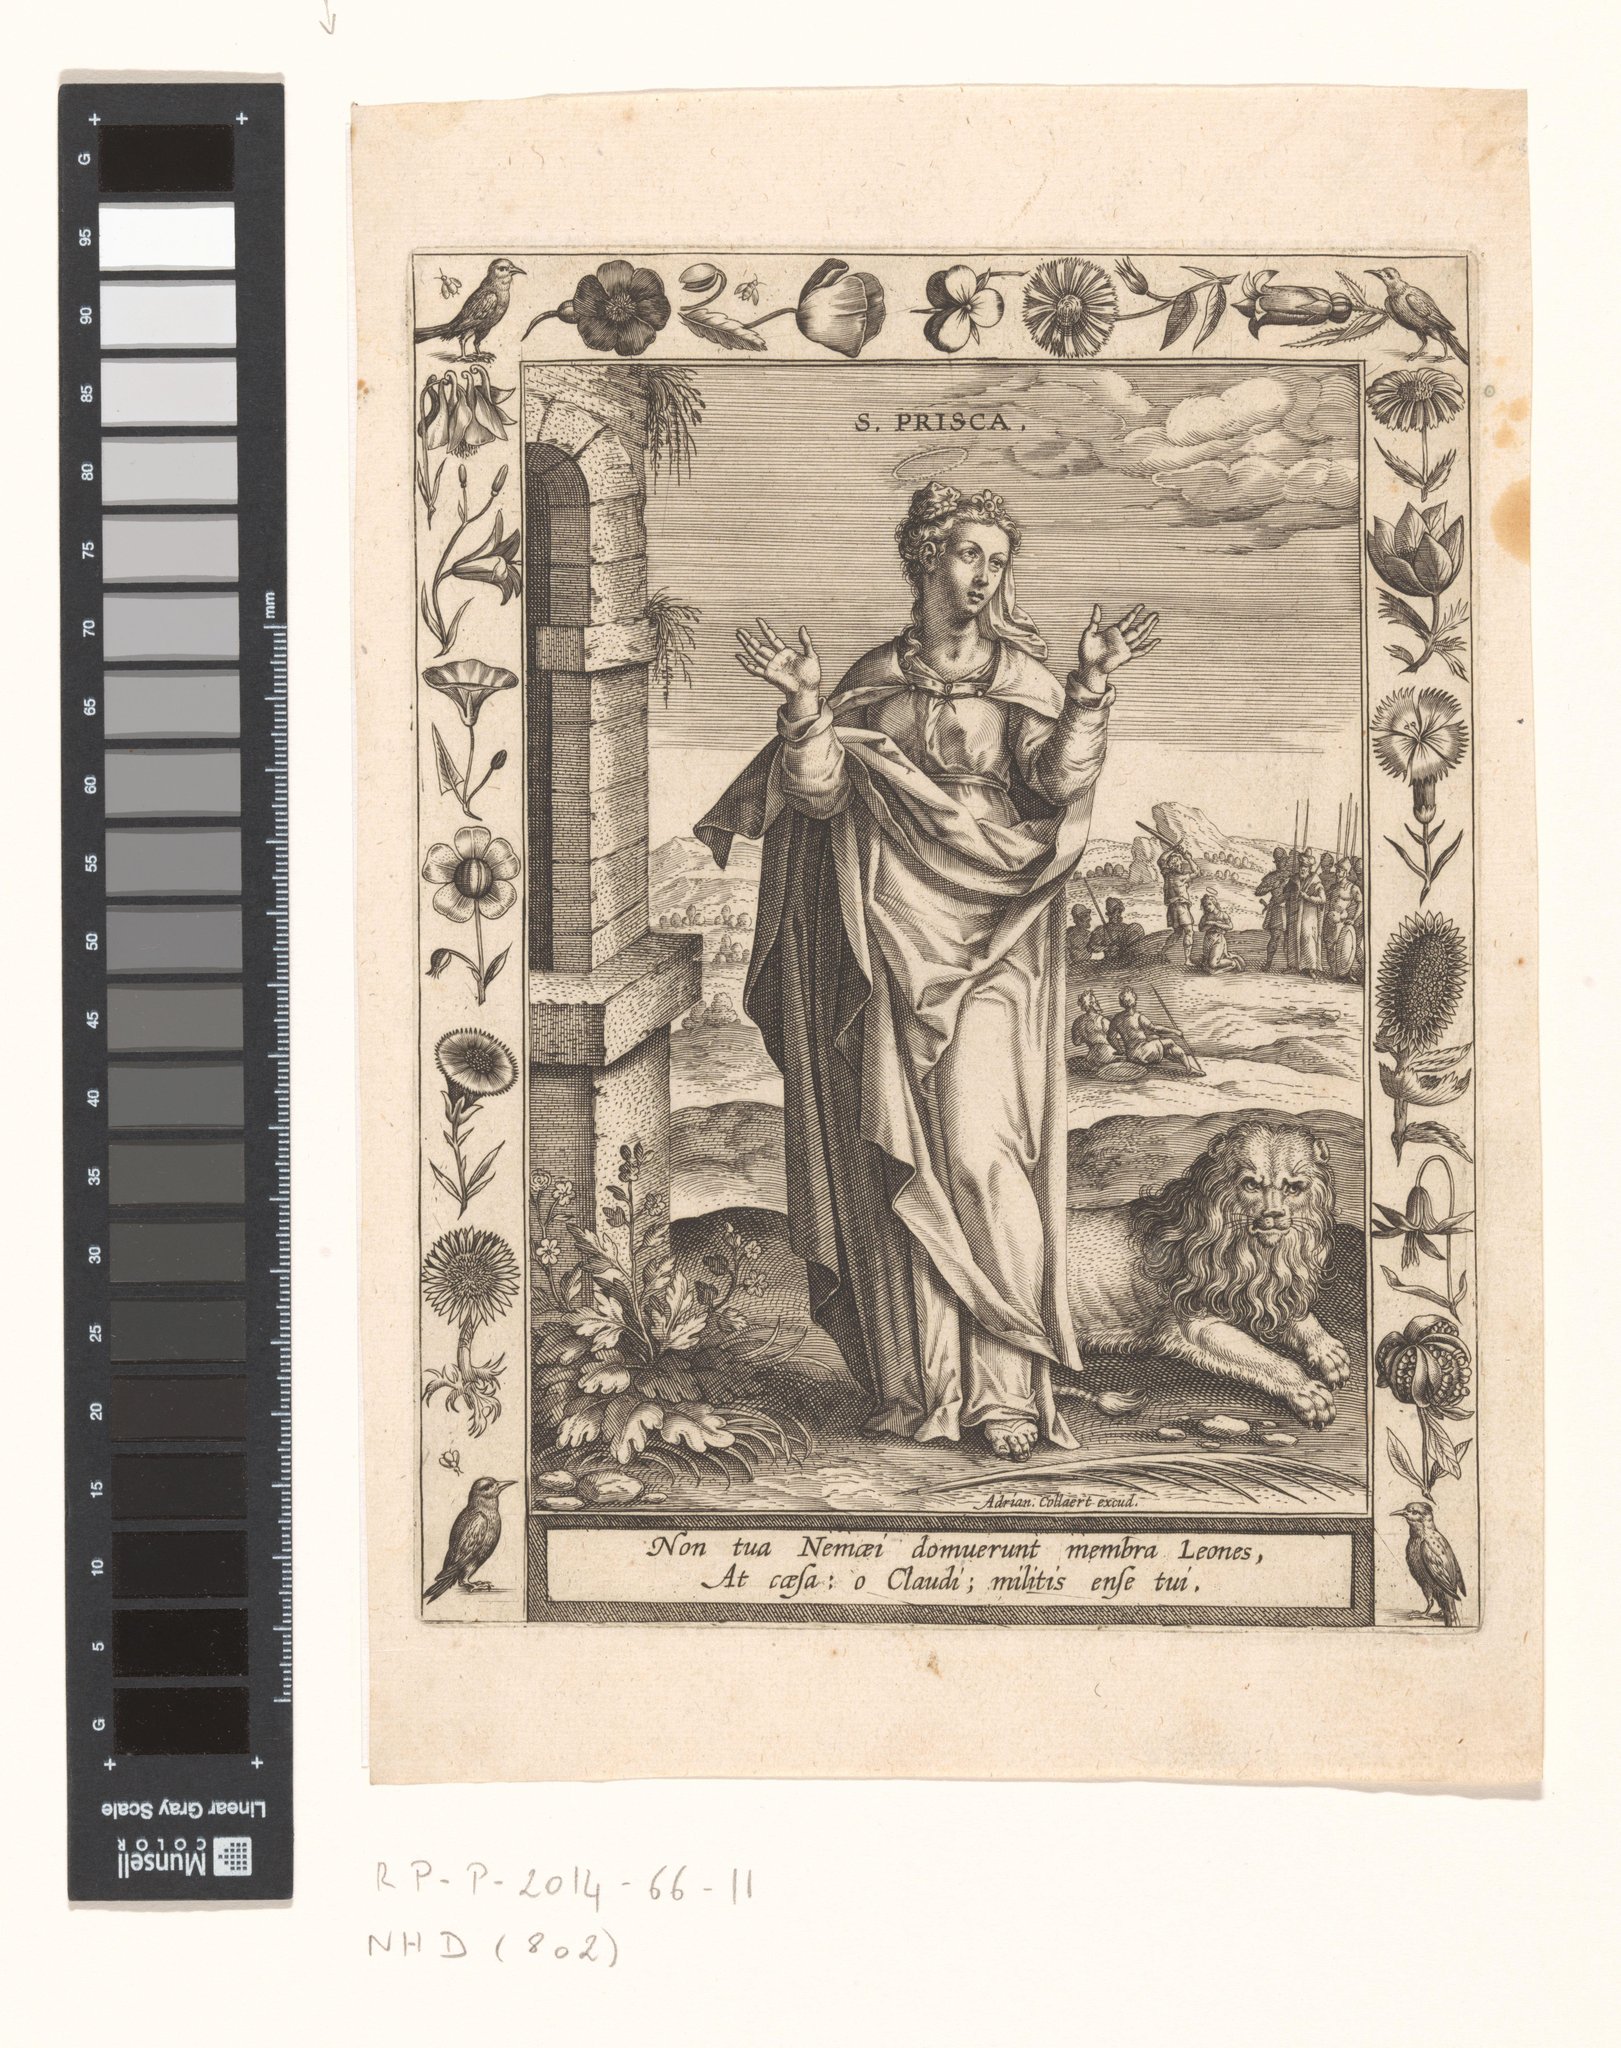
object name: print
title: Heilige Prisca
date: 1590-1610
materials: paper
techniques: engraving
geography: antwerp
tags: flowers, female saints (prisca)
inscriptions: collector's mark: Lugt 2760, collector's mark: Lugt 2228, collector's mark: Lugt 3751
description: Heilige Prisca. Onderdeel van een serie van 24 voorstellingen van vrouwelijke martelaren (martyrologium). De voorstellingen zijn voorzien van randen met bloemen en dieren.